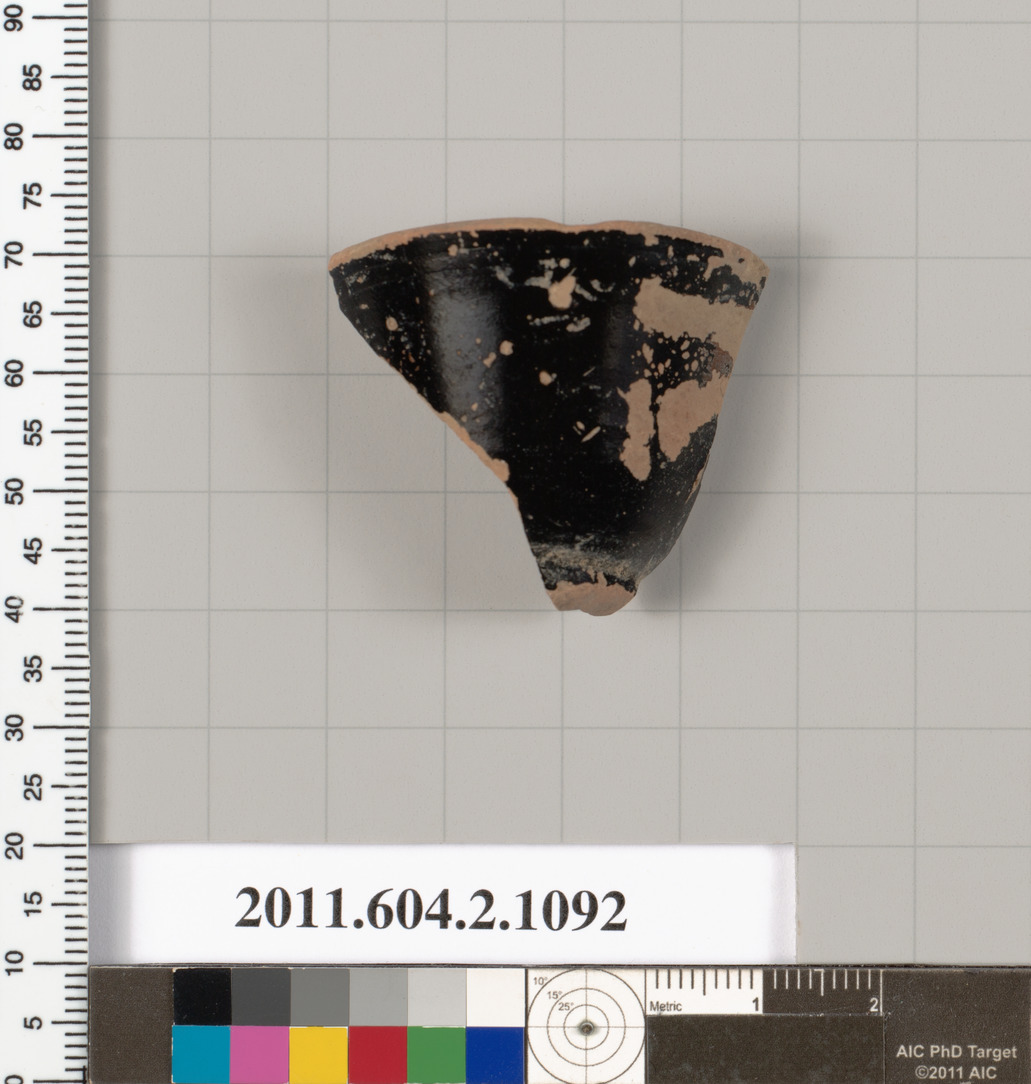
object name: lekythos fragment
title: Terracotta fragment of a lekythos (oil flask)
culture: greek, attic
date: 500-451 BCE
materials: terracotta